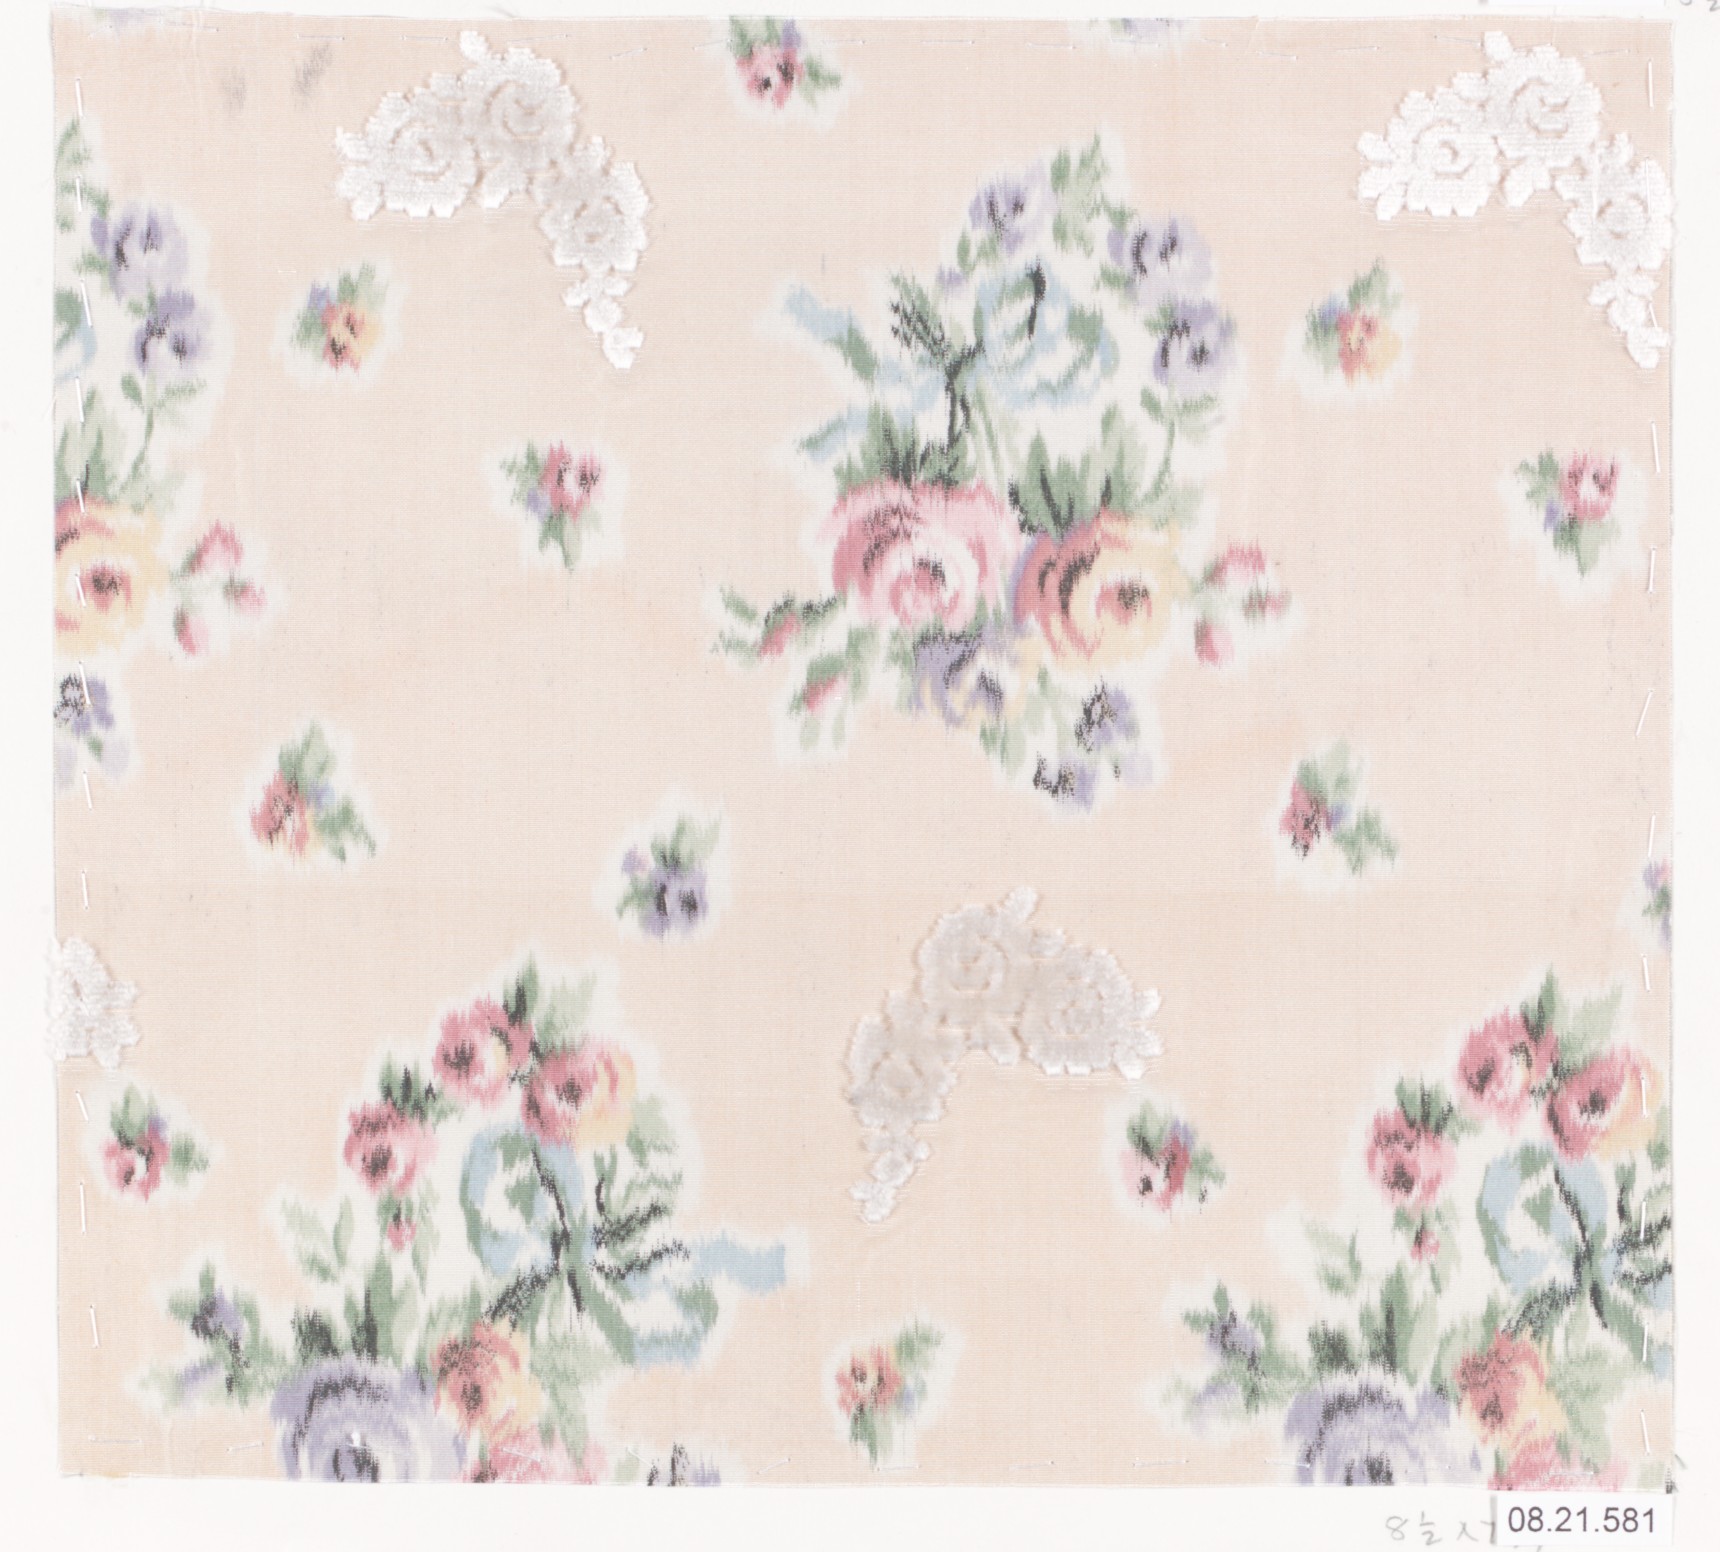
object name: textile sample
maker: Anonymous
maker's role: designer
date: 1900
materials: silk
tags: flowers